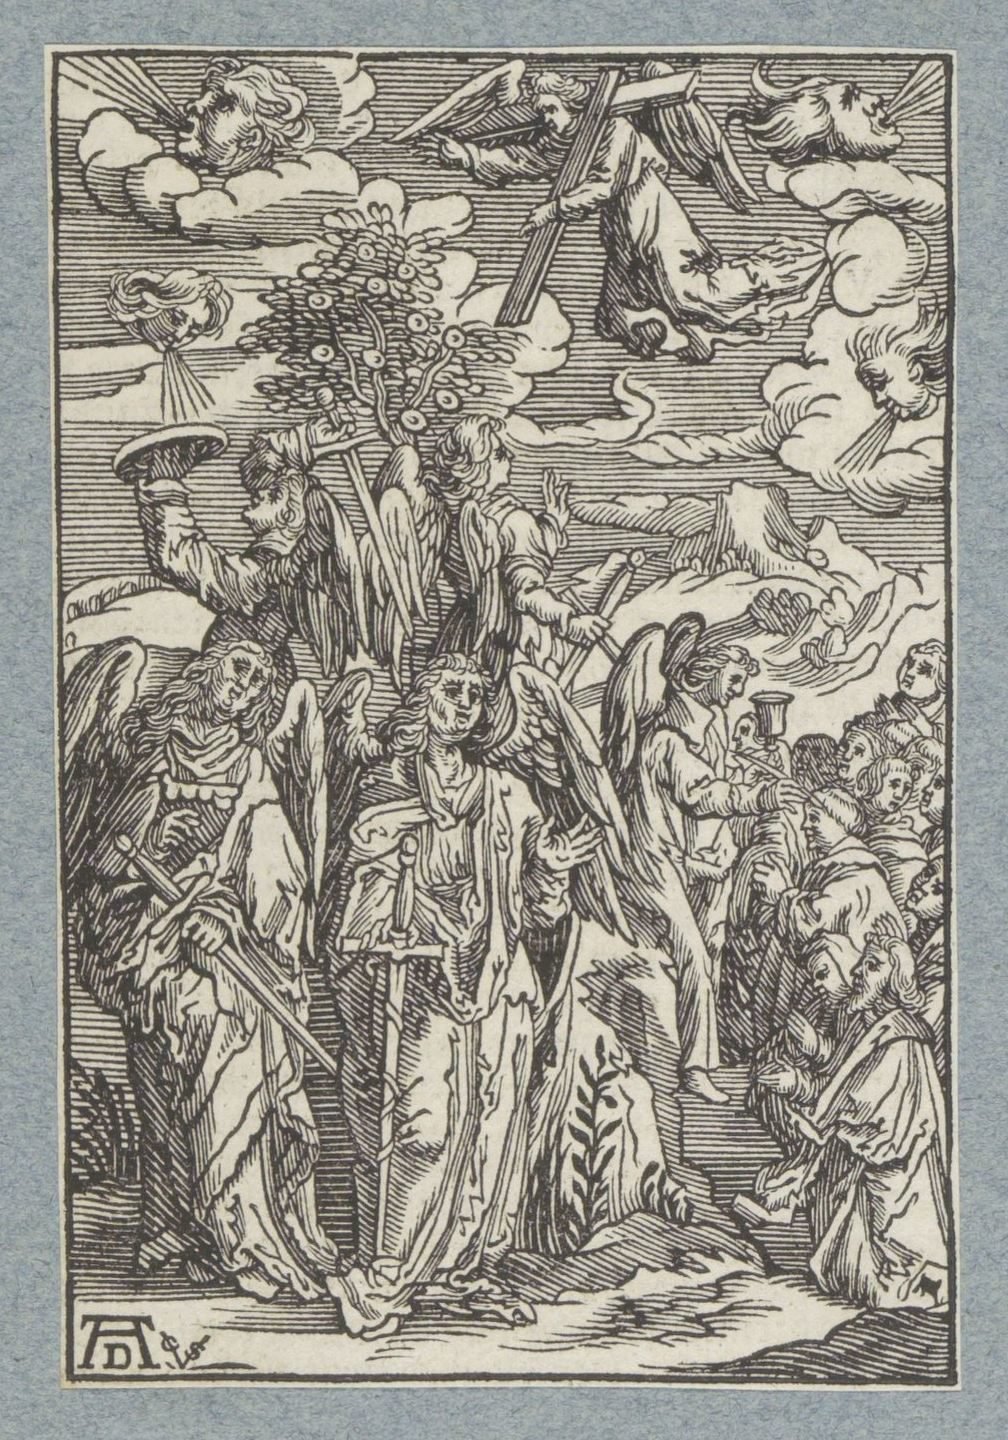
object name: album leaf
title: Engelen houden de vier winden tegen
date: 1629-1646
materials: paper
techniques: letterpress printing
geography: nuremberg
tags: the four winds are restrained by four angels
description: De prent is afkomstig uit een van de uitgaven van P.J. Paets uit Amsterdam. De prent wordt mogelijk al gebruikt in: Der Zielen Lust-hof. Leuven, I.Jacbosz voor P.J. Paets [= Amsterdam, P.J. Paets], 1629. Ze komt in ieder geval voor in: Het Nieuwe Testament ons Salichmaeckers Jesu Christi. Amsterdam, P.J. Paets, 1646.